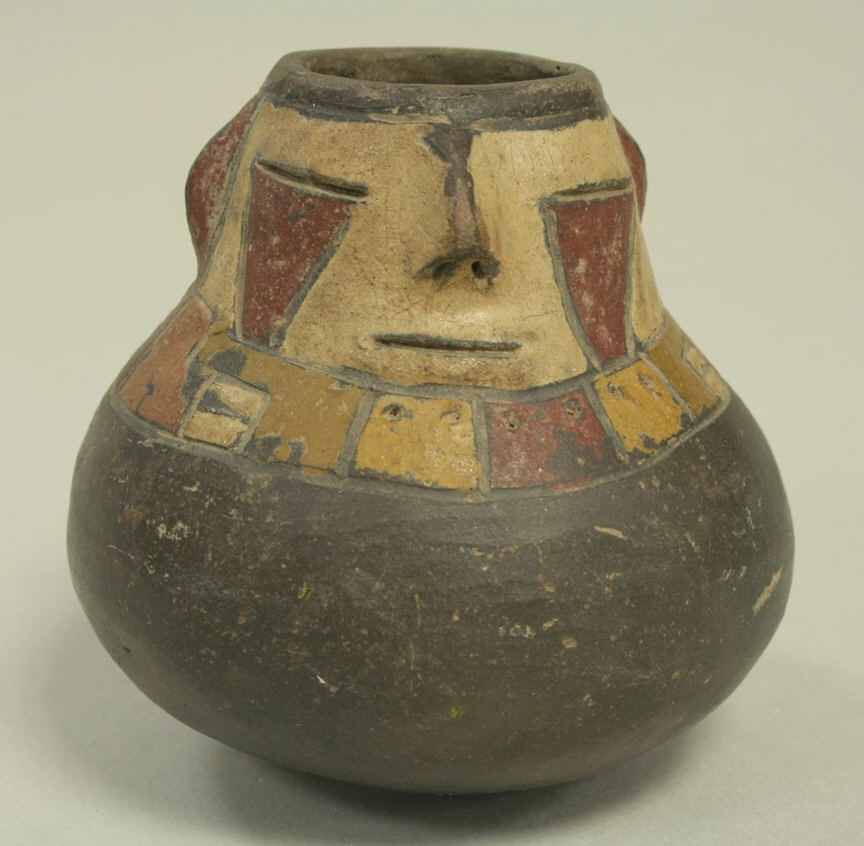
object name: bottle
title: Miniature Effigy Vessel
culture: paracas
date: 300-201 BCE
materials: ceramic, paint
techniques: firing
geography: peru